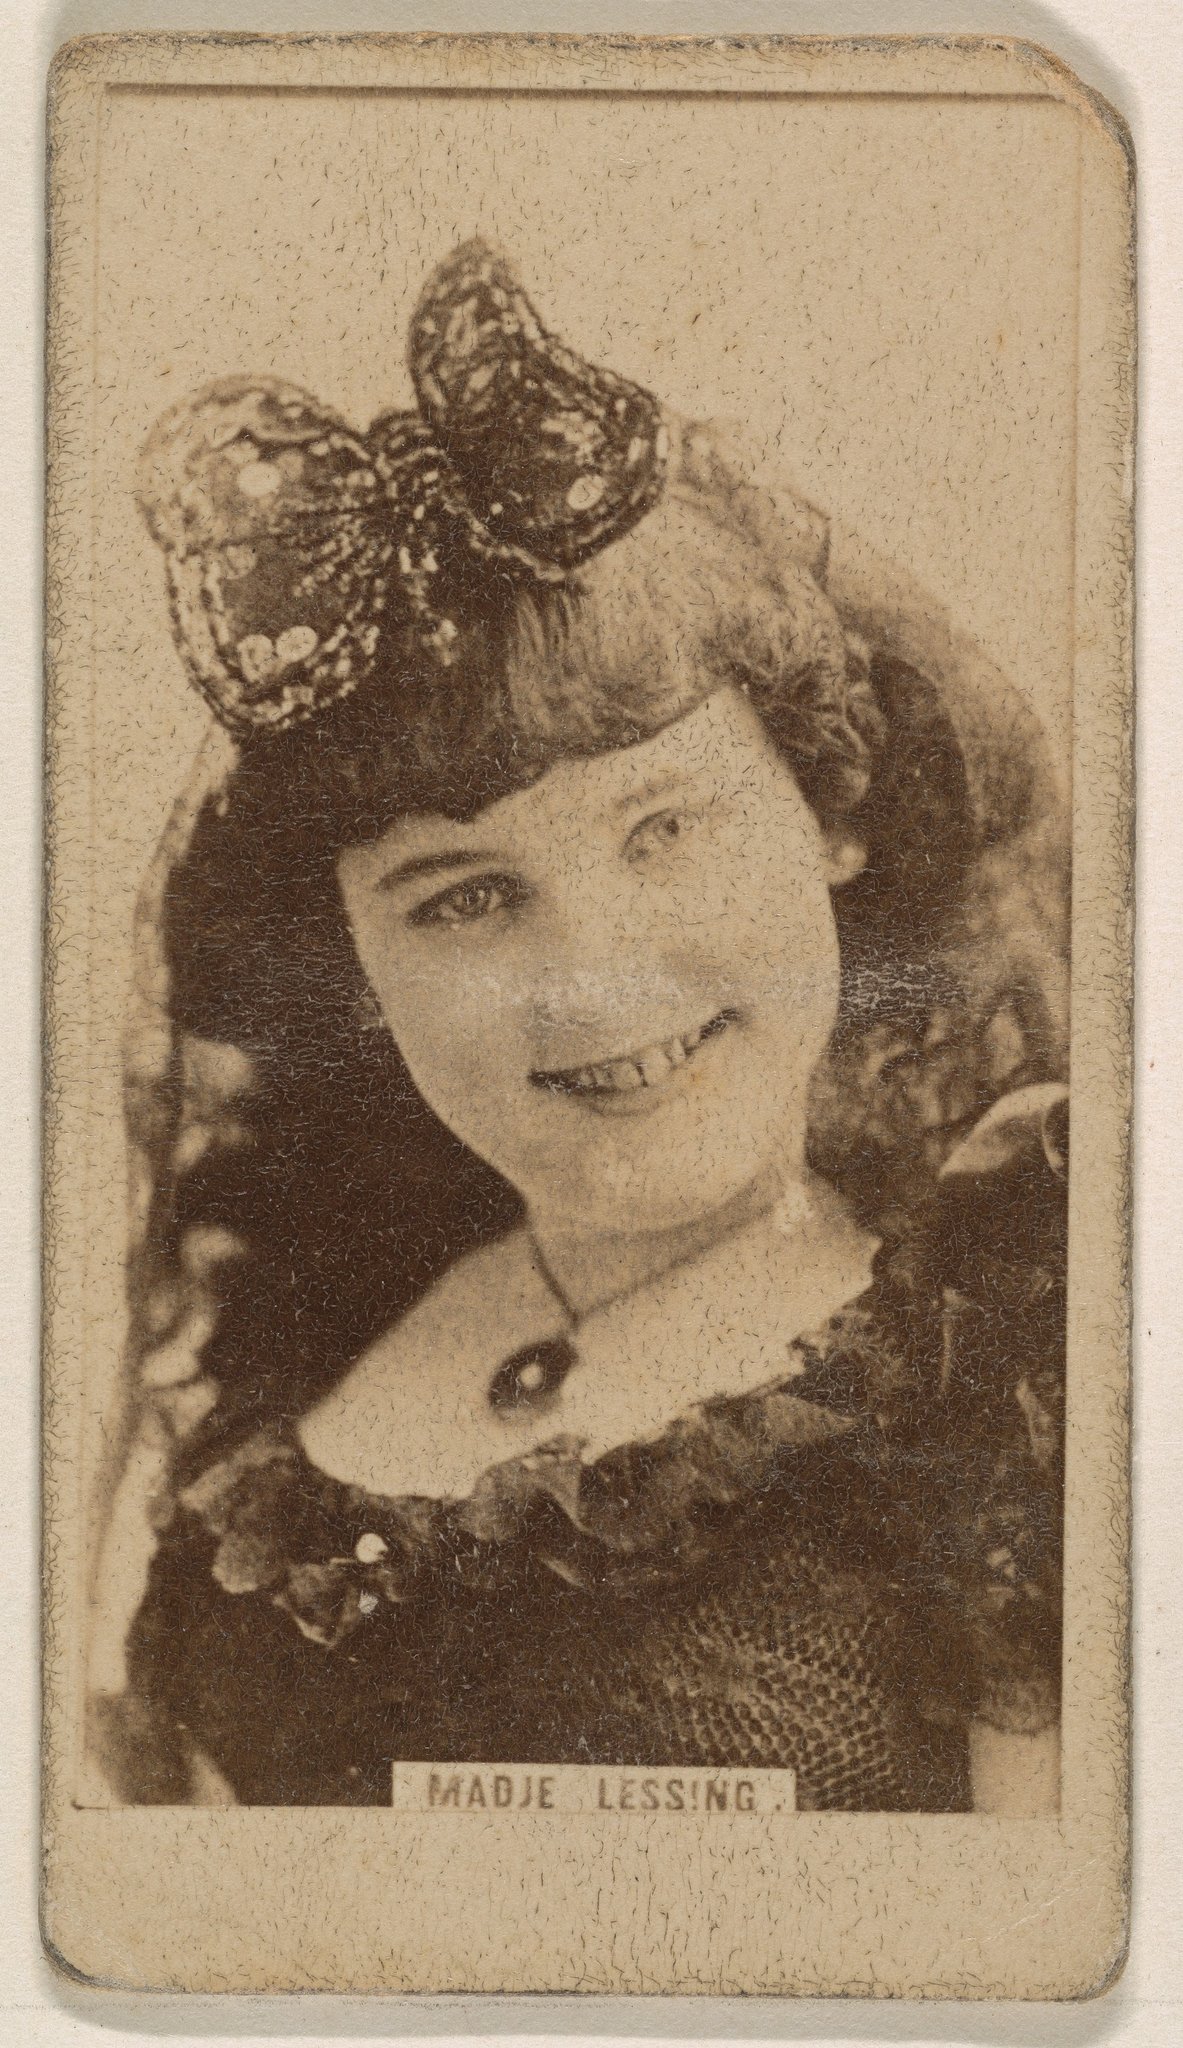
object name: photograph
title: Madje Lessing, from the Actresses series (N245) issued by Kinney Brothers to promote Sweet Caporal Cigarettes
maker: kinney brothers tobacco company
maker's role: publisher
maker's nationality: american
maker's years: 1869-2011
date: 1890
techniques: albumen silver print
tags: portraits,women,actresses